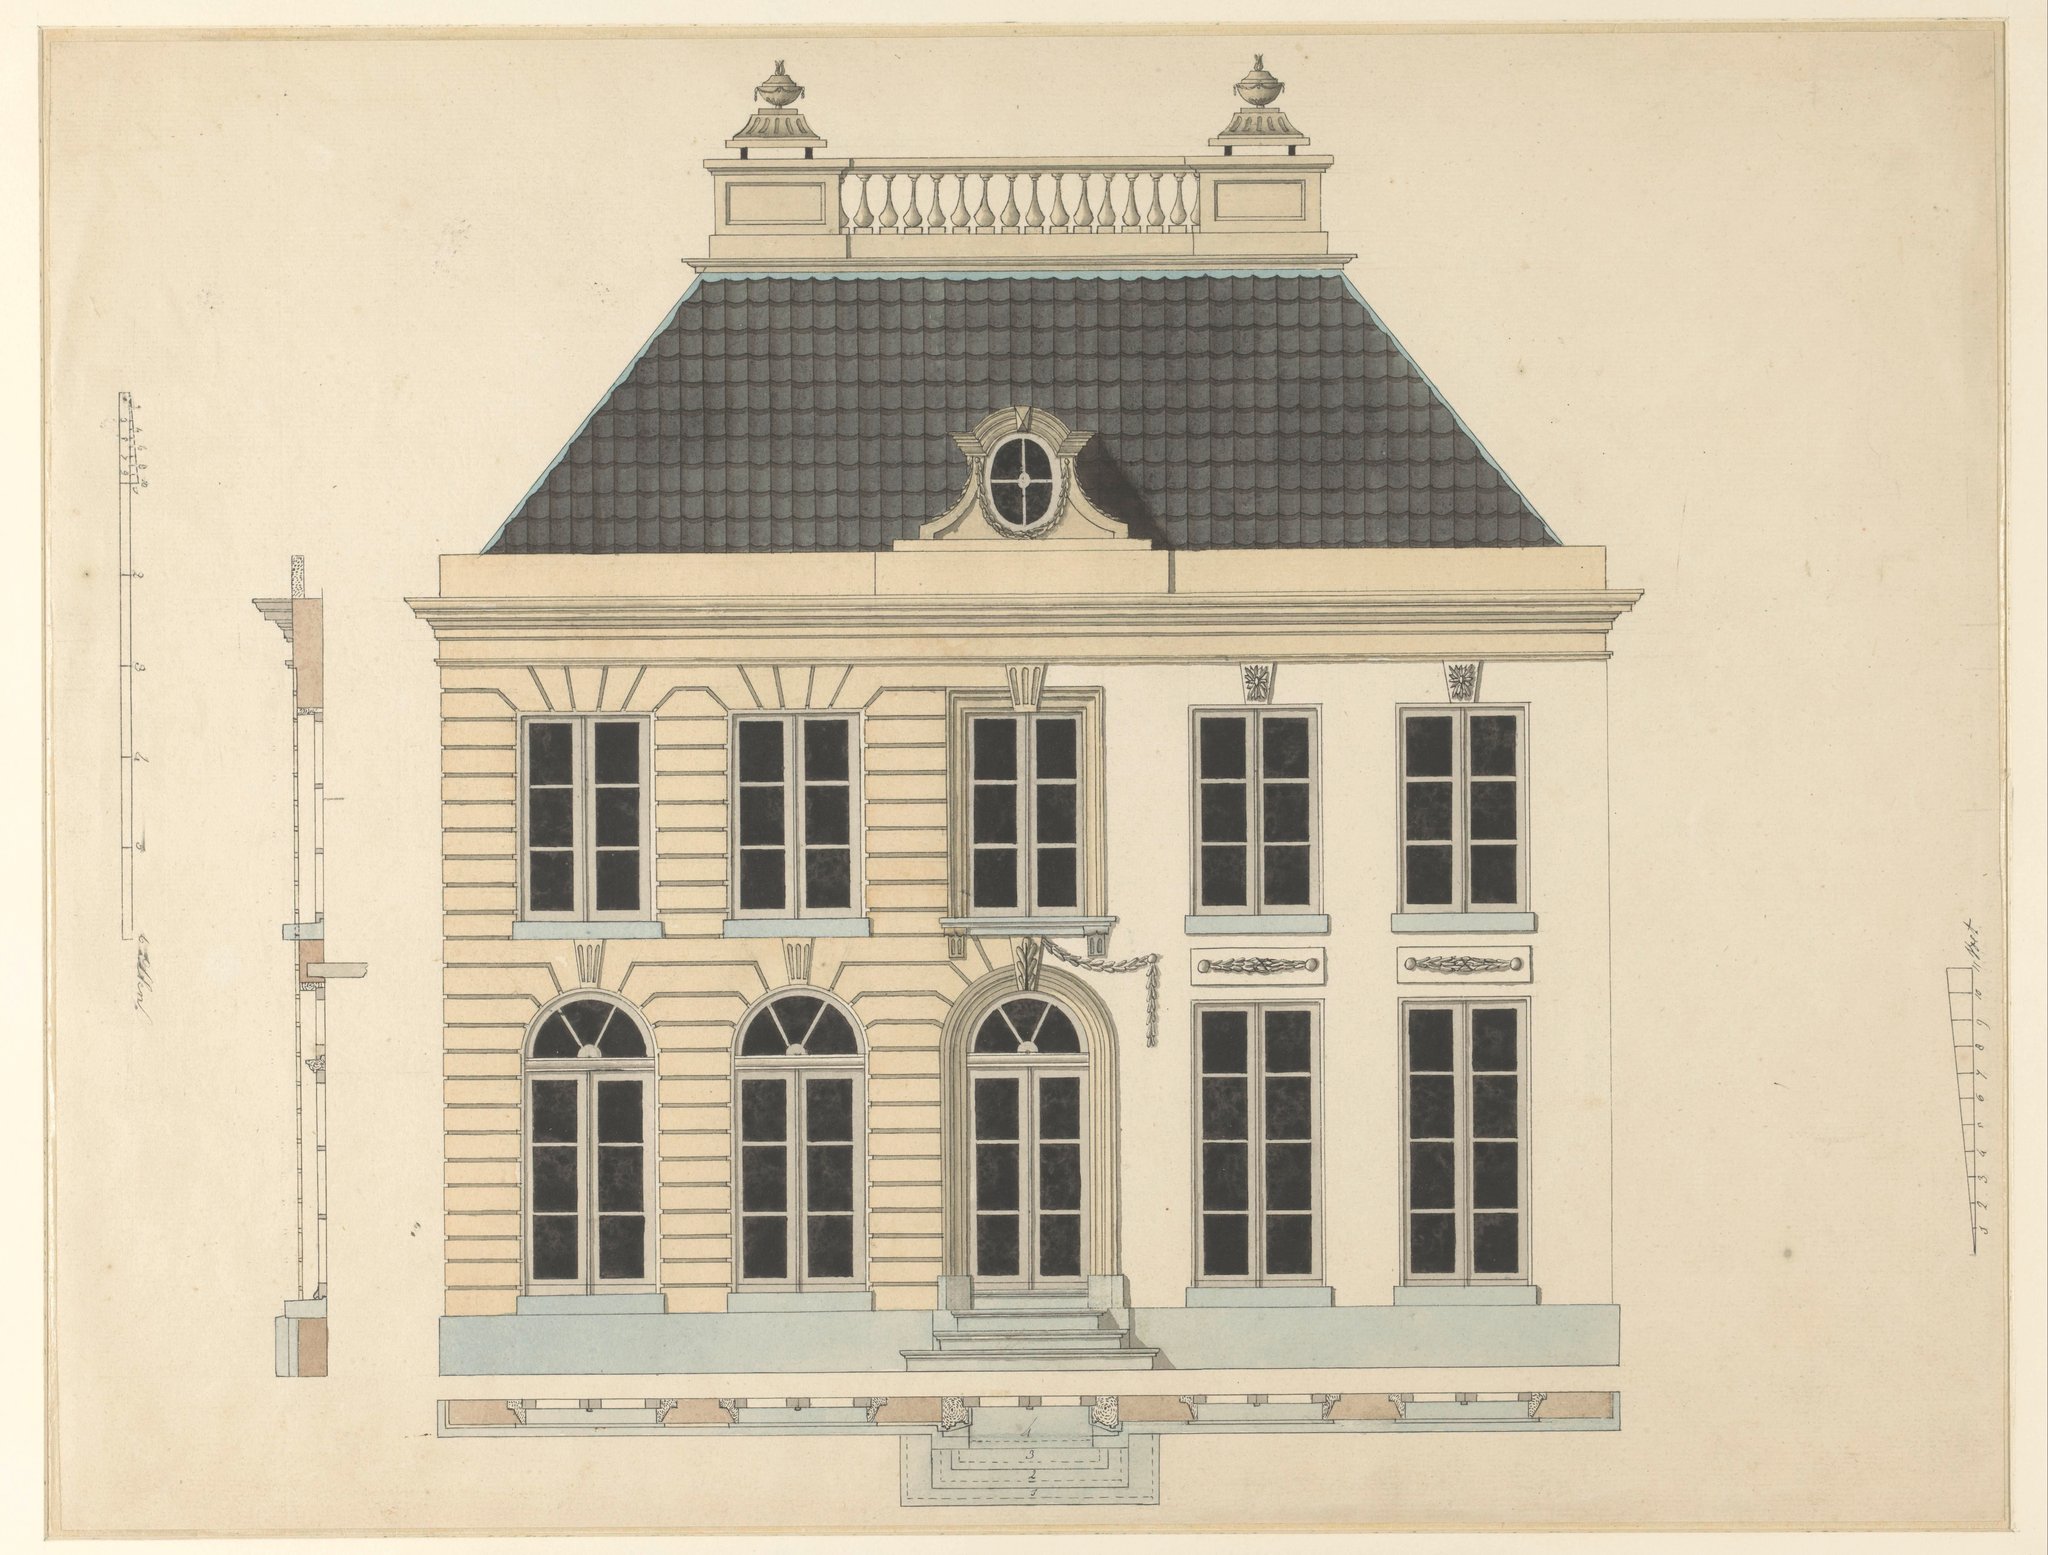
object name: drawing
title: Ontwerp voor een voorgevel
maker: wybrand tollenaar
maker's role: draughtsman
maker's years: 1778-1852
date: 1788-1852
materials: ink, paper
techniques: brush, pen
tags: façade (of house or building), civic architecture; edifices; dwellings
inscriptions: collector's mark: Lugt 2228